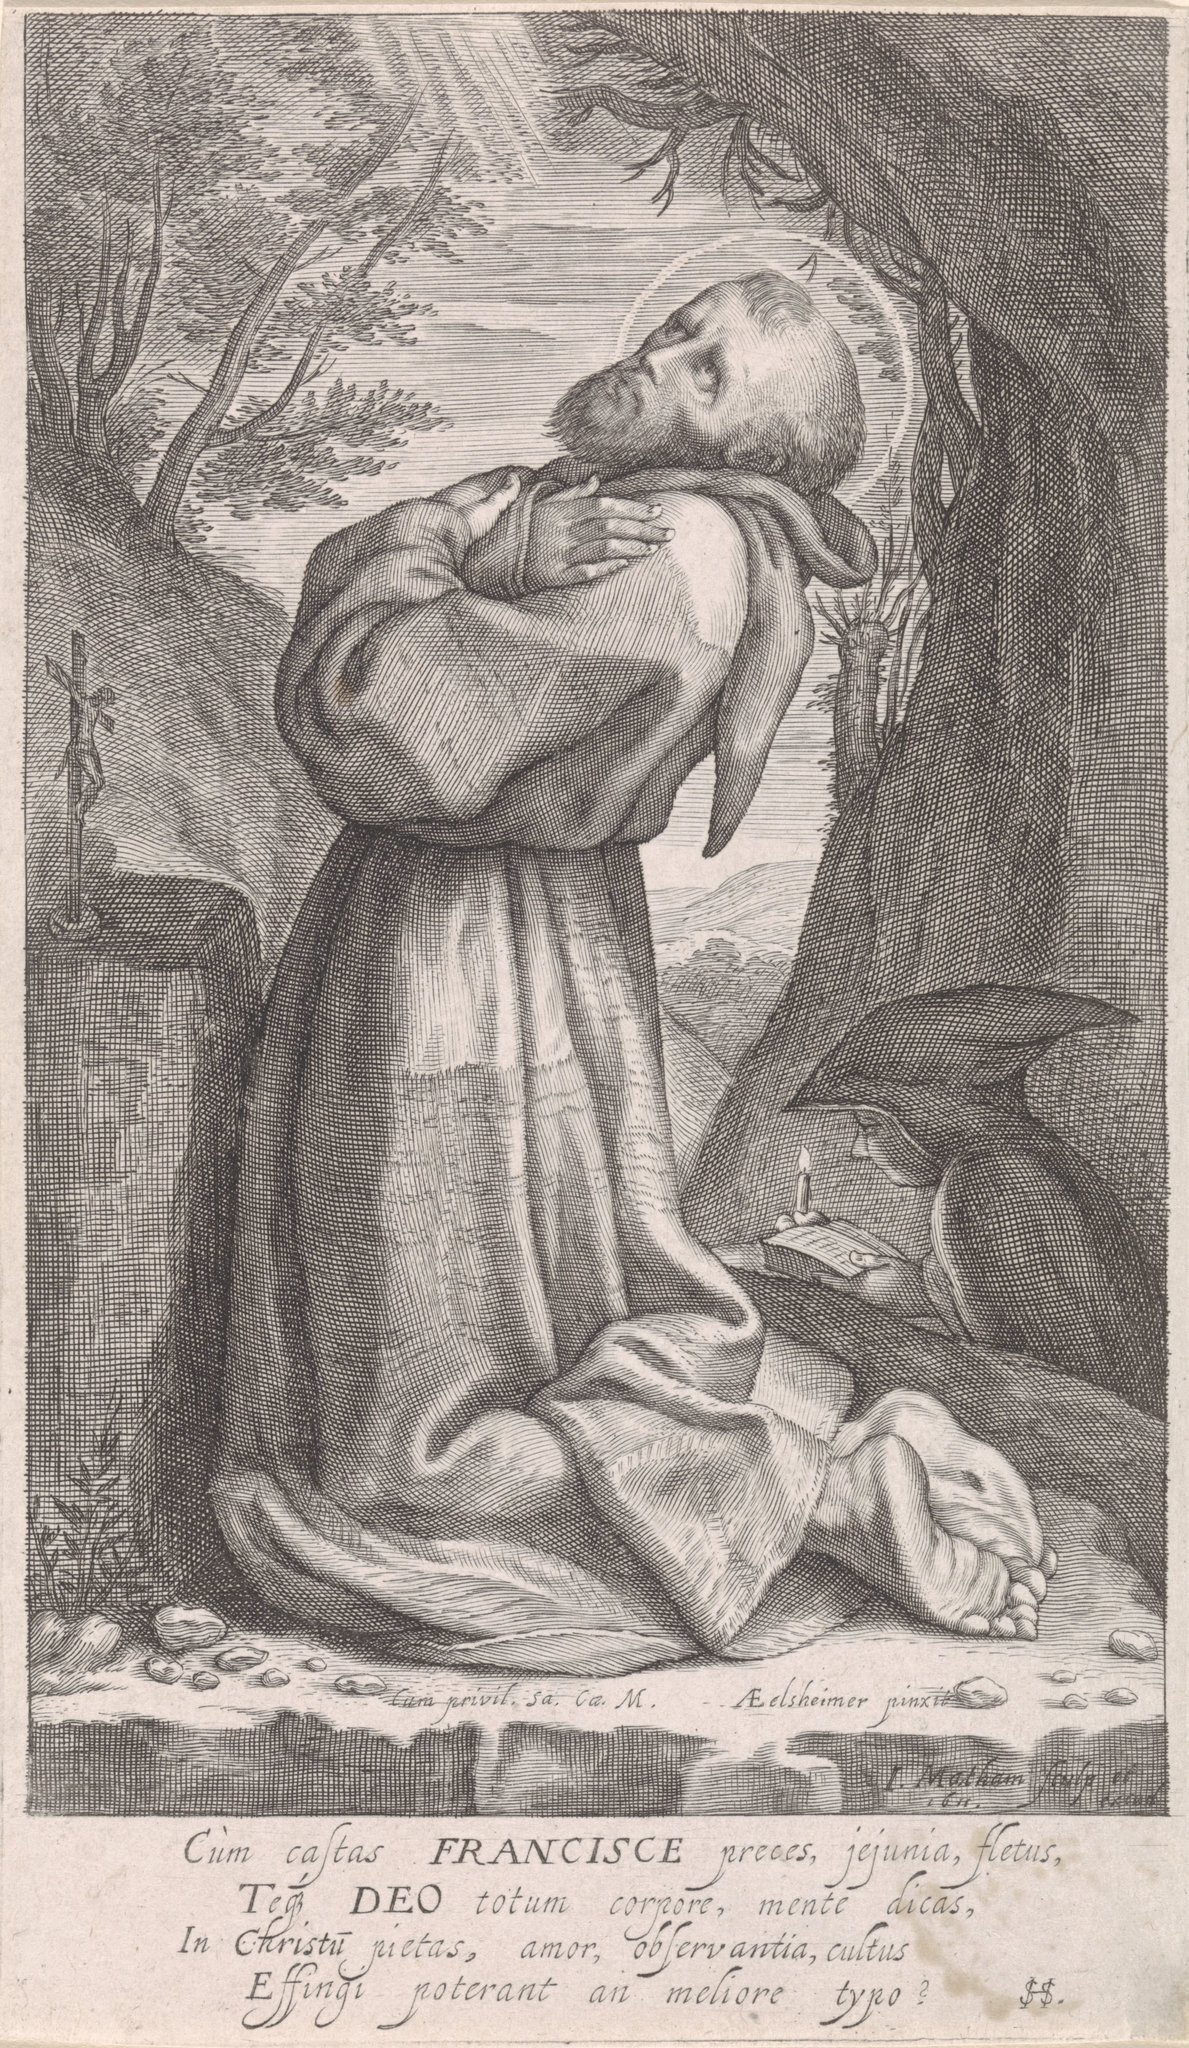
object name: print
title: H. Franciscus biddend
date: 1611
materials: paper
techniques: engraving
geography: haarlem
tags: founder of the order of friars minor (franciscans), francis(cus) of assisi; possible attributes: book, crucifix, lily, skull, stigmata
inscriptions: collector's mark: Lugt 240